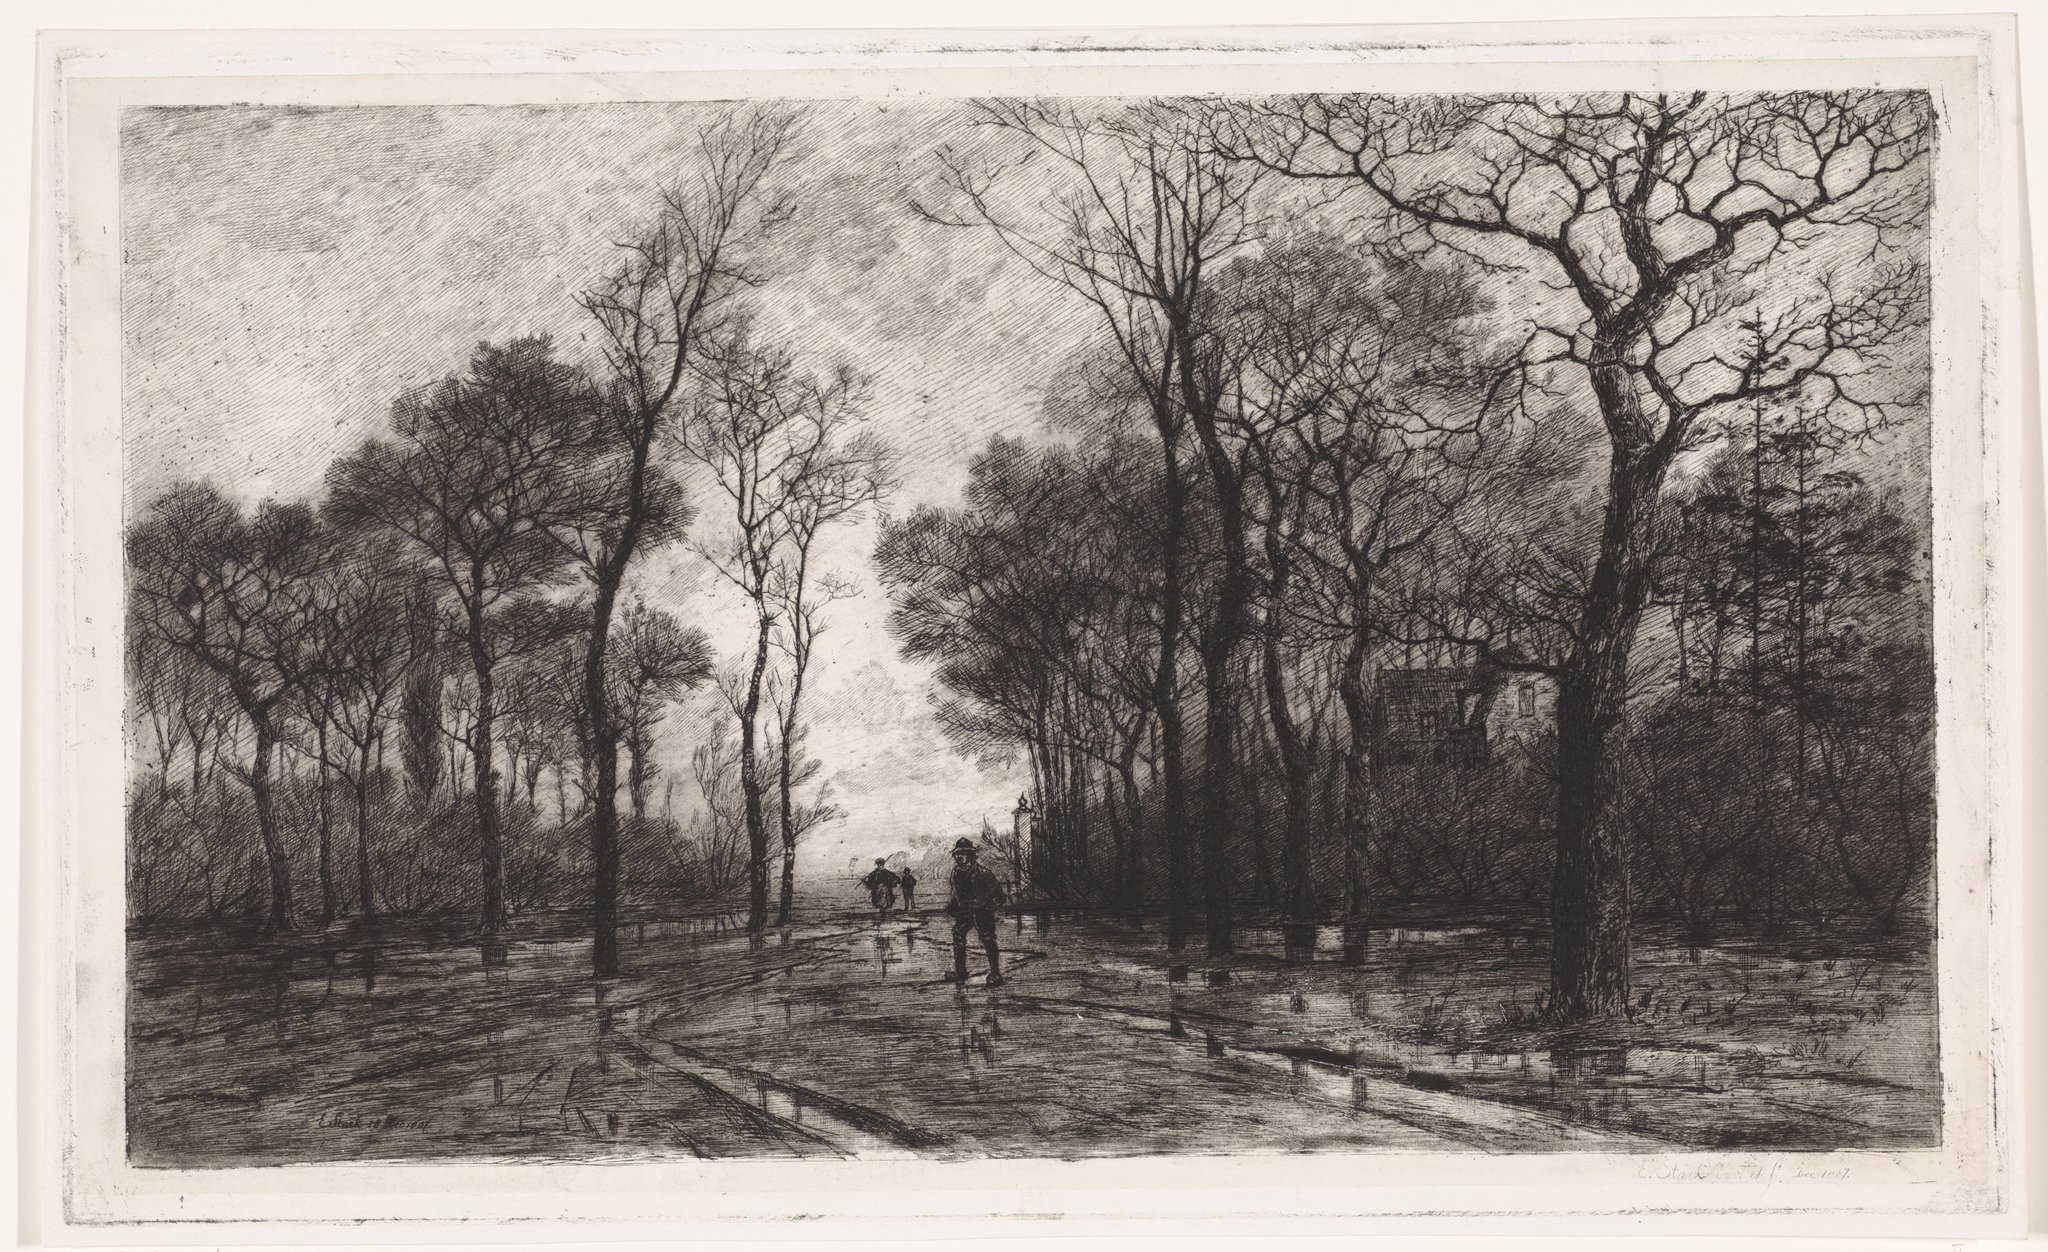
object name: print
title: Drie mensen op een weg met aan weerskanten bomen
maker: elias stark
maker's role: draughtsman, print maker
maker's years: 1849-1933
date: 1887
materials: paper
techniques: aquatint, etching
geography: nieuwer-amstel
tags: trees, road, path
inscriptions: collector's mark: Lugt 2228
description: Tussen de bomen loopt een man op klompen. Op de grond plassen water. Op de achtergrond lopen een vrouw en een man.